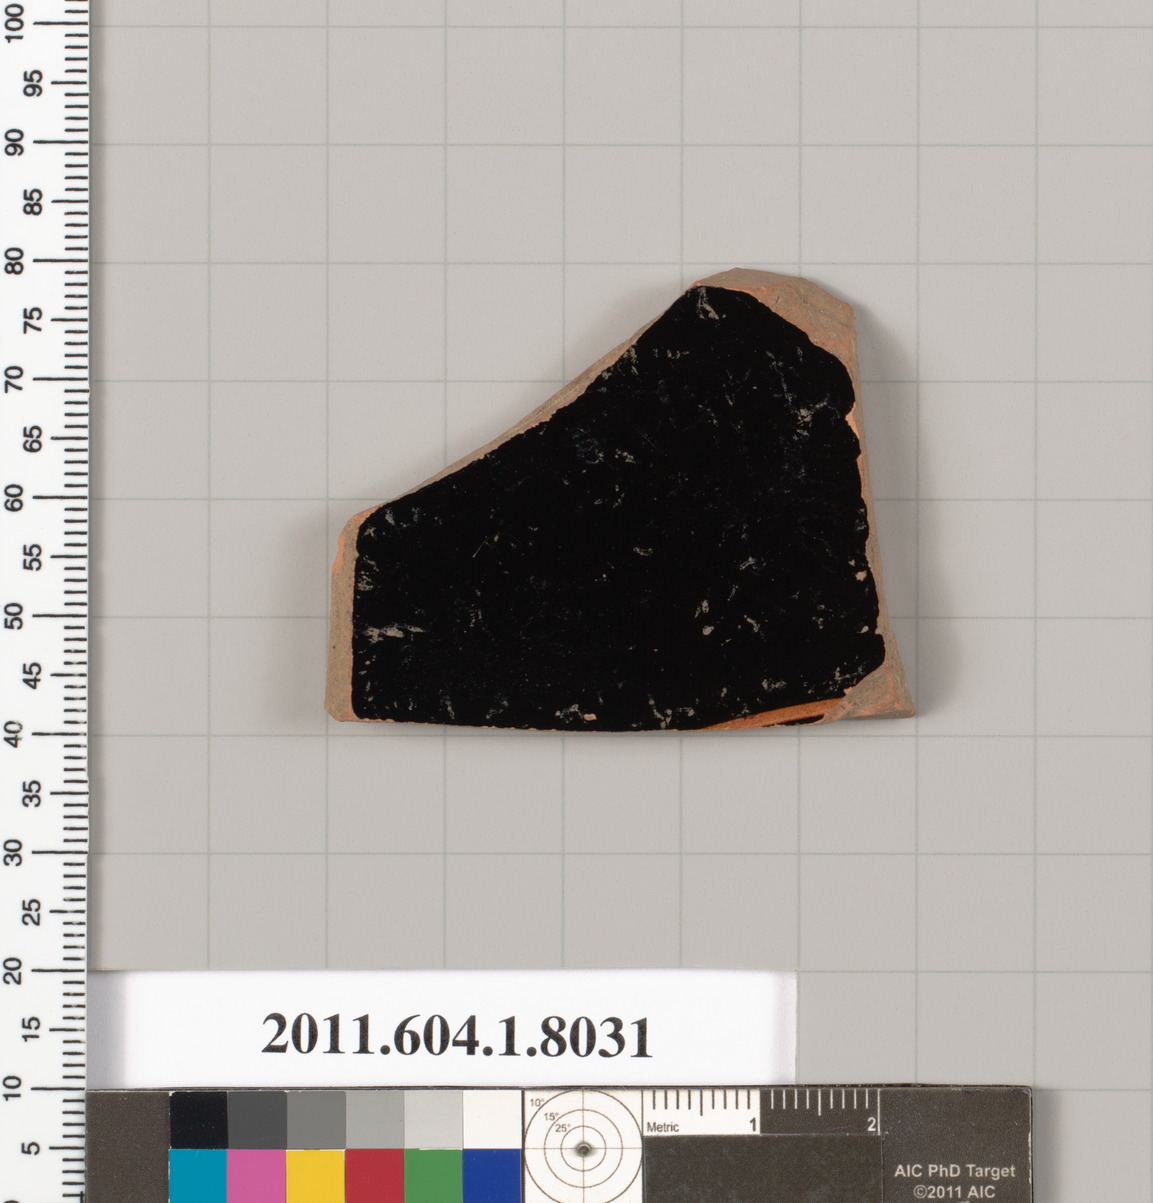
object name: kylix fragment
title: Terracotta fragment of a kylix (drinking cup)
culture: greek, attic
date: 510-500 BCE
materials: terracotta